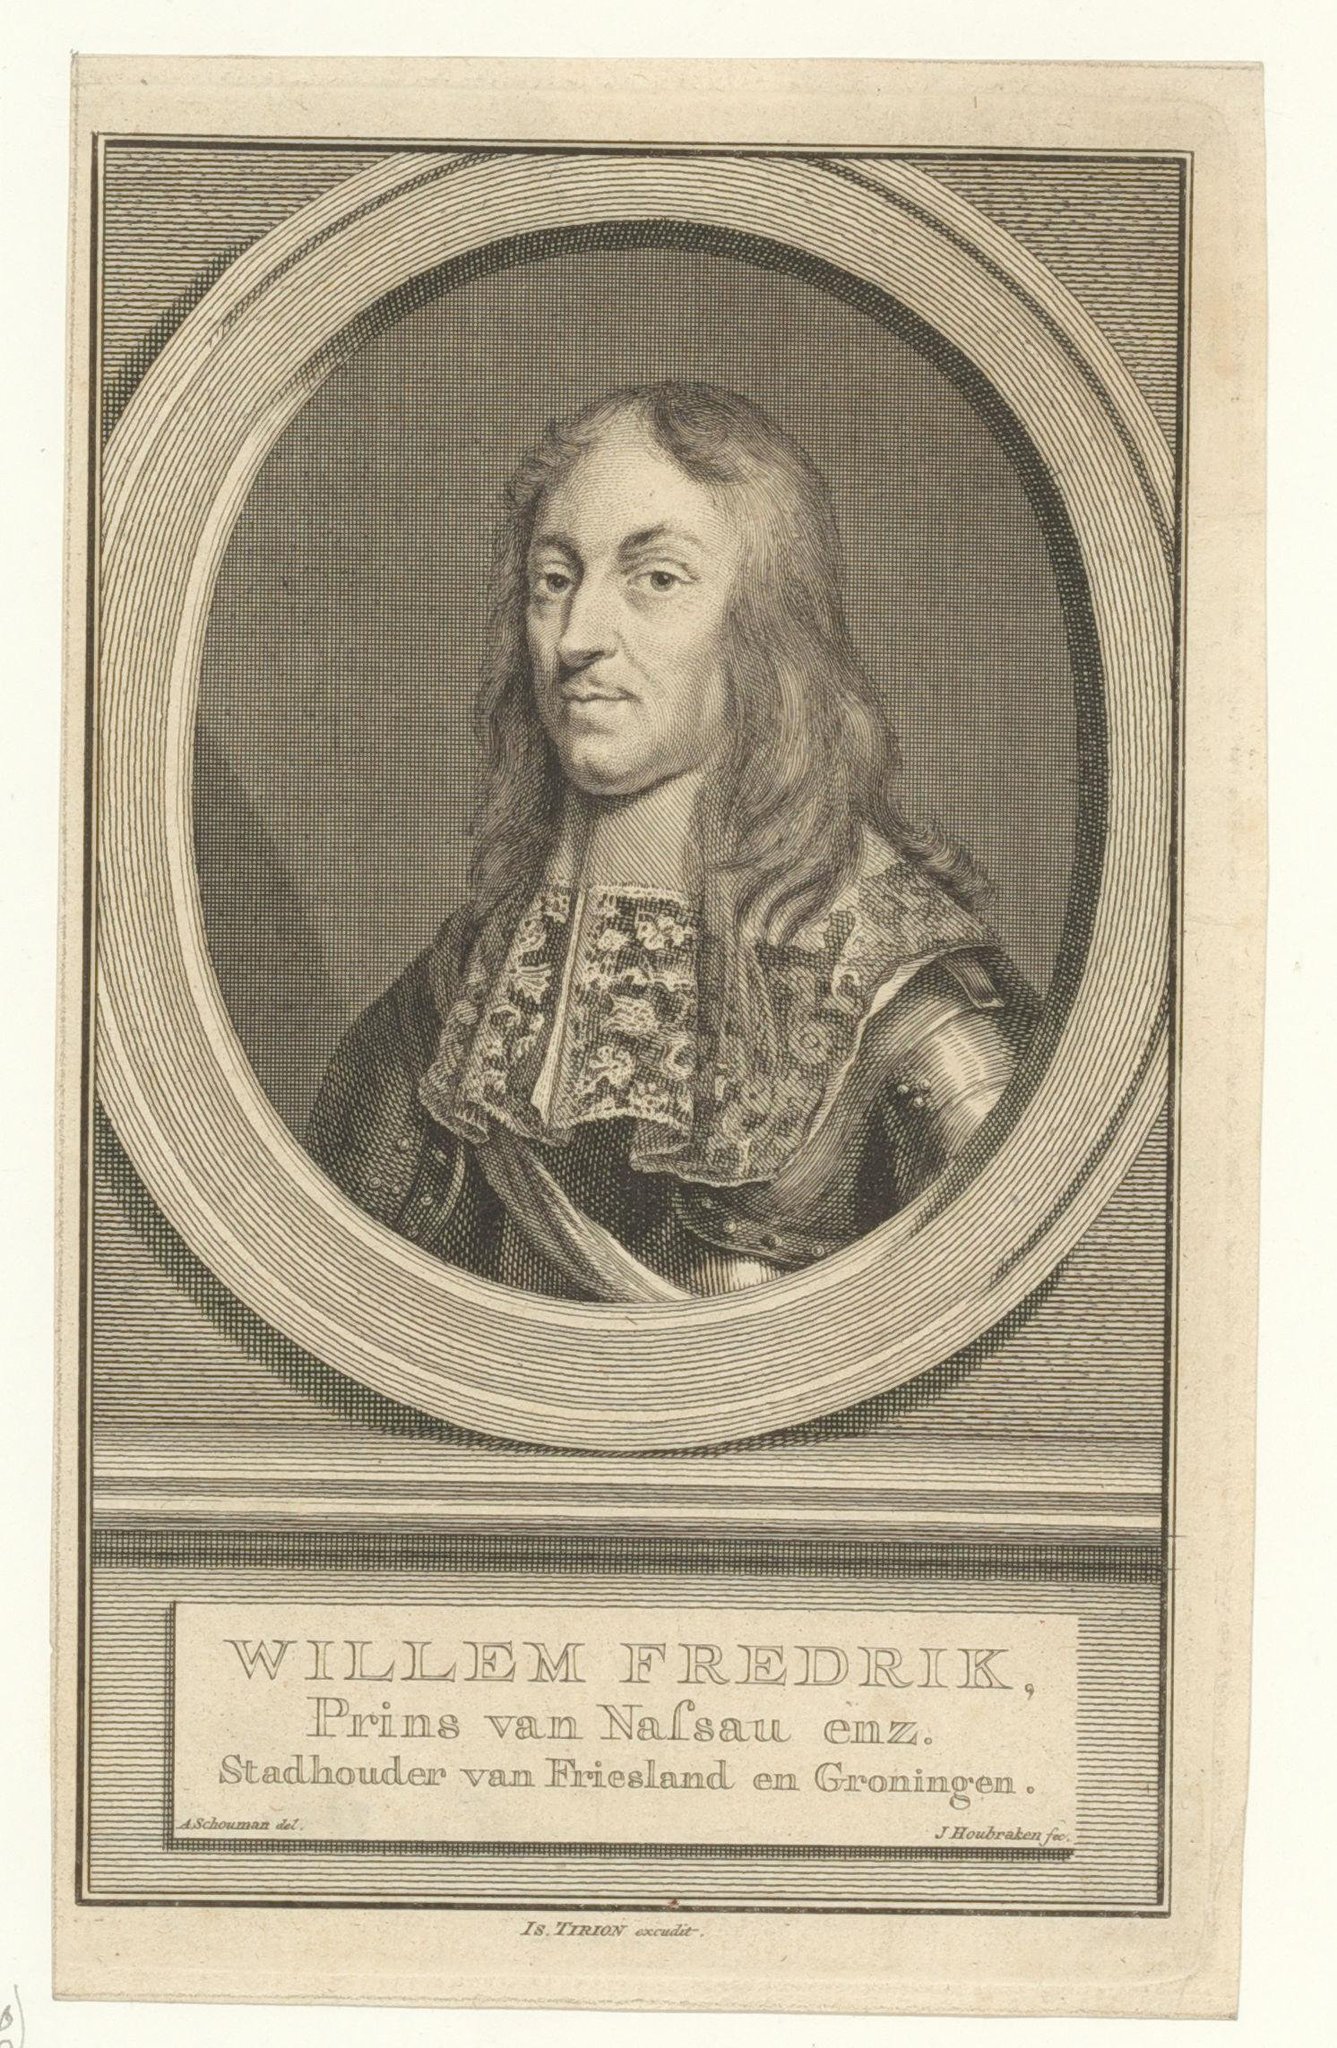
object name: print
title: Portret van Willem Frederik, graaf van Nassau-Dietz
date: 1749-1759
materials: paper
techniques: engraving, etching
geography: amsterdam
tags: arnhem, historical persons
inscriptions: stamp, collector's mark: Lugt 1641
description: Deze prent is oorspronkelijk bedoeld als aanvulling op Jan Wagenaars ‘Vaderlandsche historie’* en was zo vanaf 1796 verkrijgbaar bij Johannes Allart te Amsterdam. Voor de advertentie waarin Allart de 60 portretten en 7 platen, allen gegraveerd door Houbraken, ter aanvulling op Wagenaars ‘Vaderlandsche historie’ aanbiedt, zie RP-P-OB-77.766. *Van dit werk zijn in de achttiende eeuw meerdere uitgaves verschenen, zoals: Wagenaar, Jan. Vaderlandsche historie, vervattende de geschiedenissen der Vereenigde Nederlanden (…). 21 delen. Amsterdam: Isaak Tirion, 1749-1759. Wagenaar, Jan. Vaderlandsche historie, vervattende de geschiedenissen der nu Vereenigde Nederlanden (…). 21 delen. Amsterdam: weduwe Isaak Tirion, 1770. Wagenaar, Jan. Vaderlandsche historie, vervattende de geschiedenissen der nu Vereenigde Nederlanden (…). 21 delen. Amsterdam, Leiden, Dordrecht en Harlingen: P. Schouten e.a., 1782. Wagenaar, Jan. Vaderlandsche historie, vervattende de geschiedenissen der nu Vereenigde Nederlanden (…). 21 delen. Amsterdam: Johannes Allart, 1790-1796.